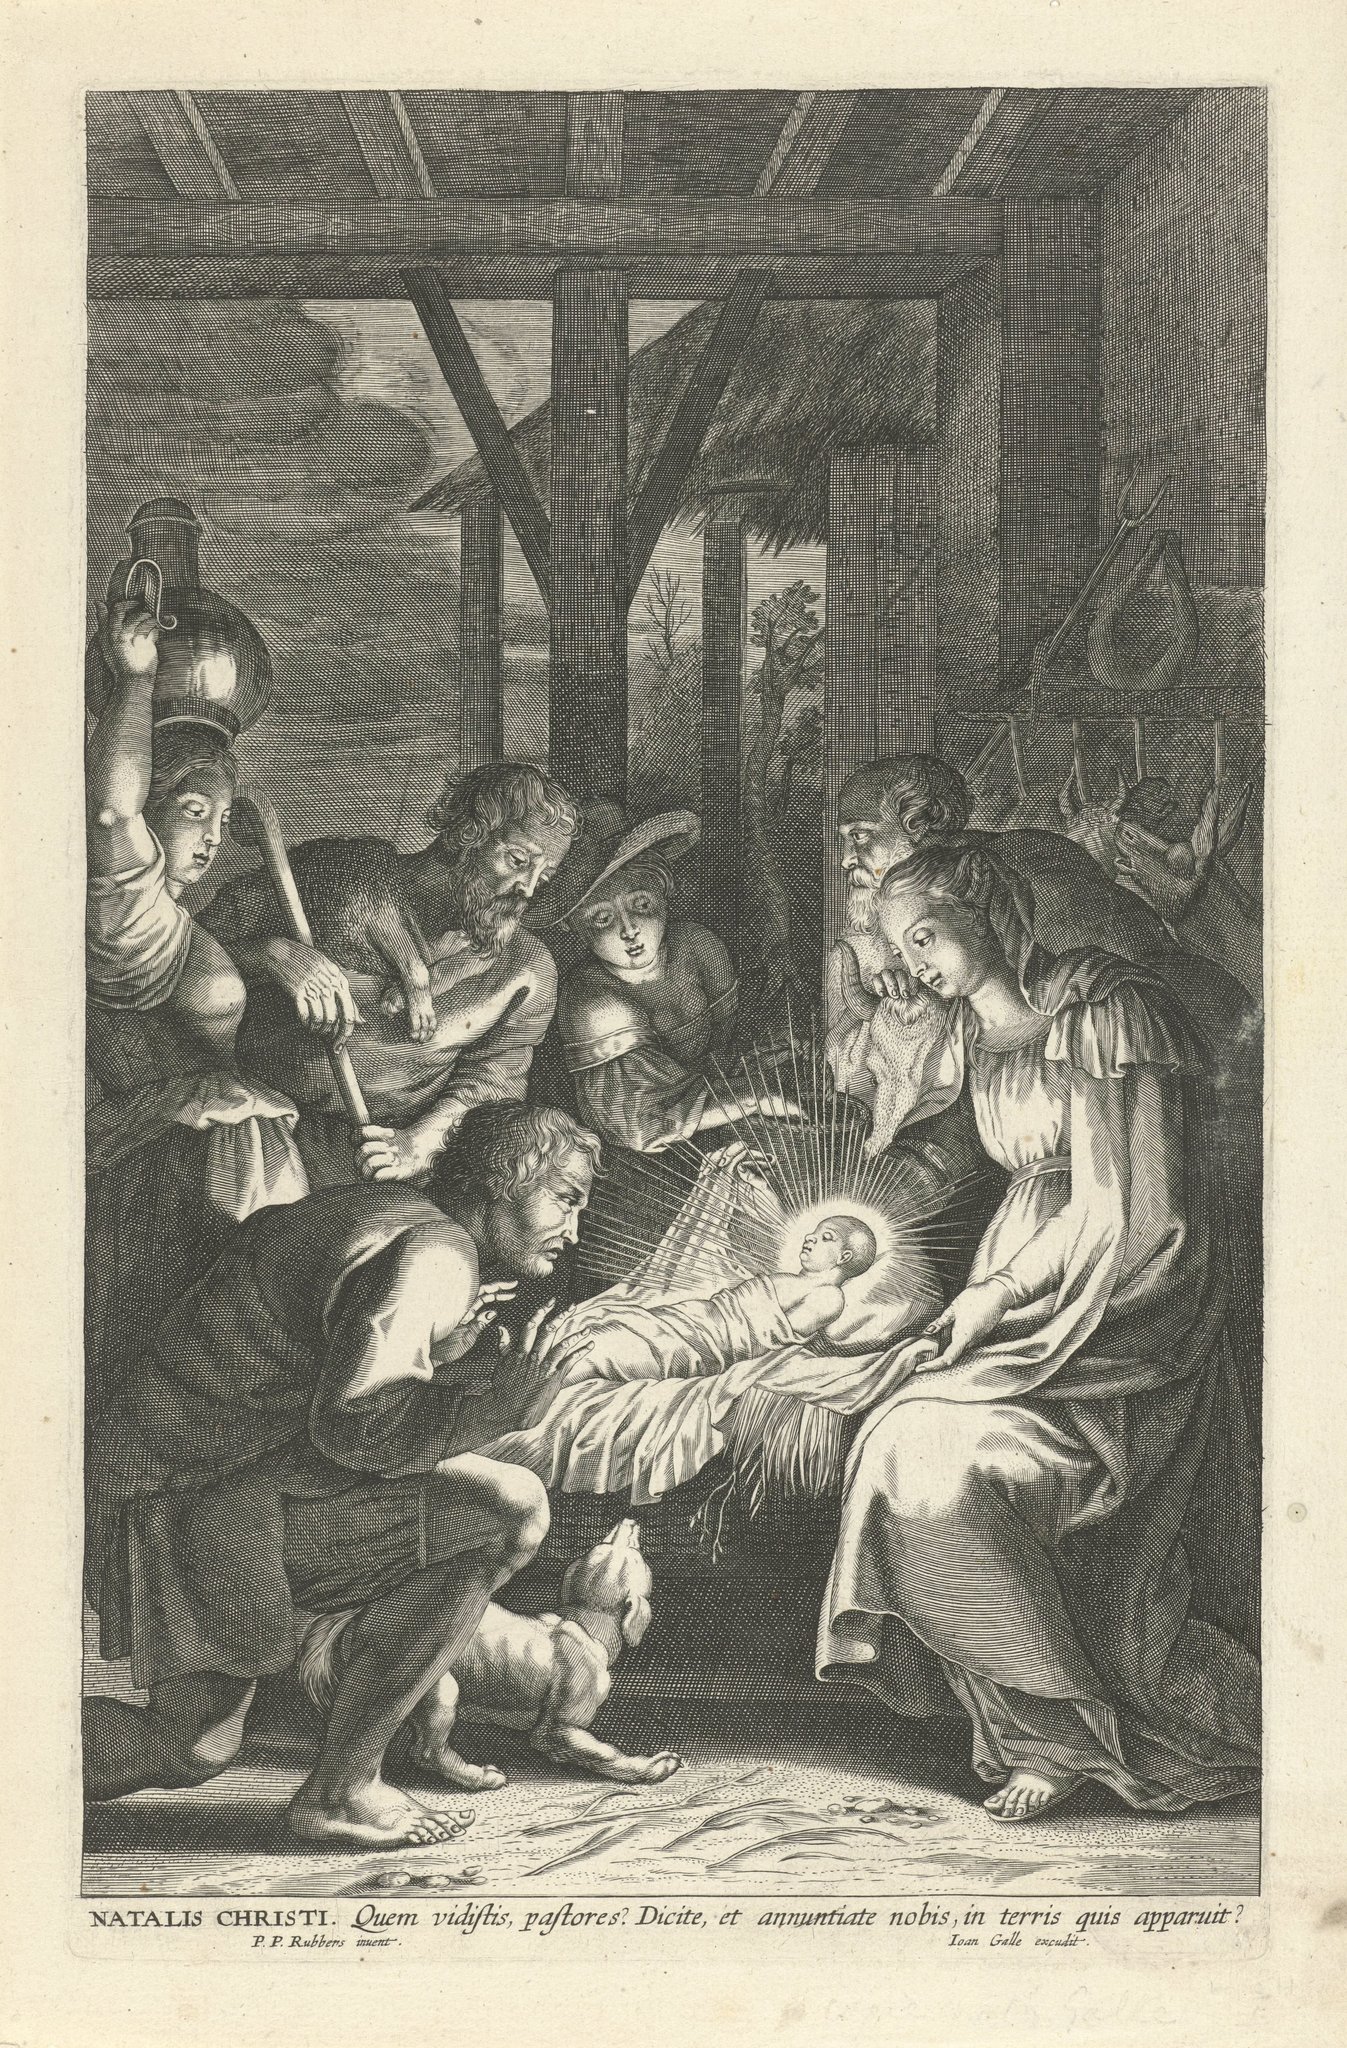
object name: print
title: Natalis Christi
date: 1614-1676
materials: paper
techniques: engraving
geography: antwerp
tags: adoration of the christ-child by the shepherds; mary and joseph present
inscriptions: collector's mark: Lugt 240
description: Herders en vrouwen bezoeken de Heilige Familie in de stal en knielen voor het Christuskind. Maria en Jozef staan achter de kribbe. Op de achtergrond liggen de os en de ezel. Kopie in spiegelbeeld. De prent heeft een Latijns onderschrift.